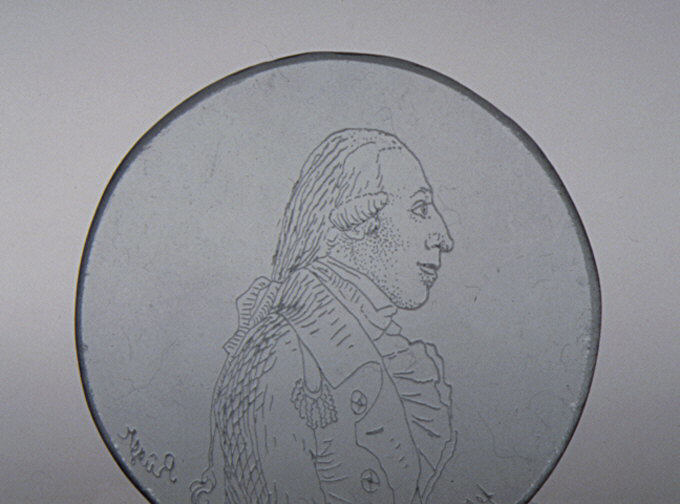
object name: medallion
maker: rüger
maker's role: maker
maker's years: 1725-1825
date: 1780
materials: glass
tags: men,profiles